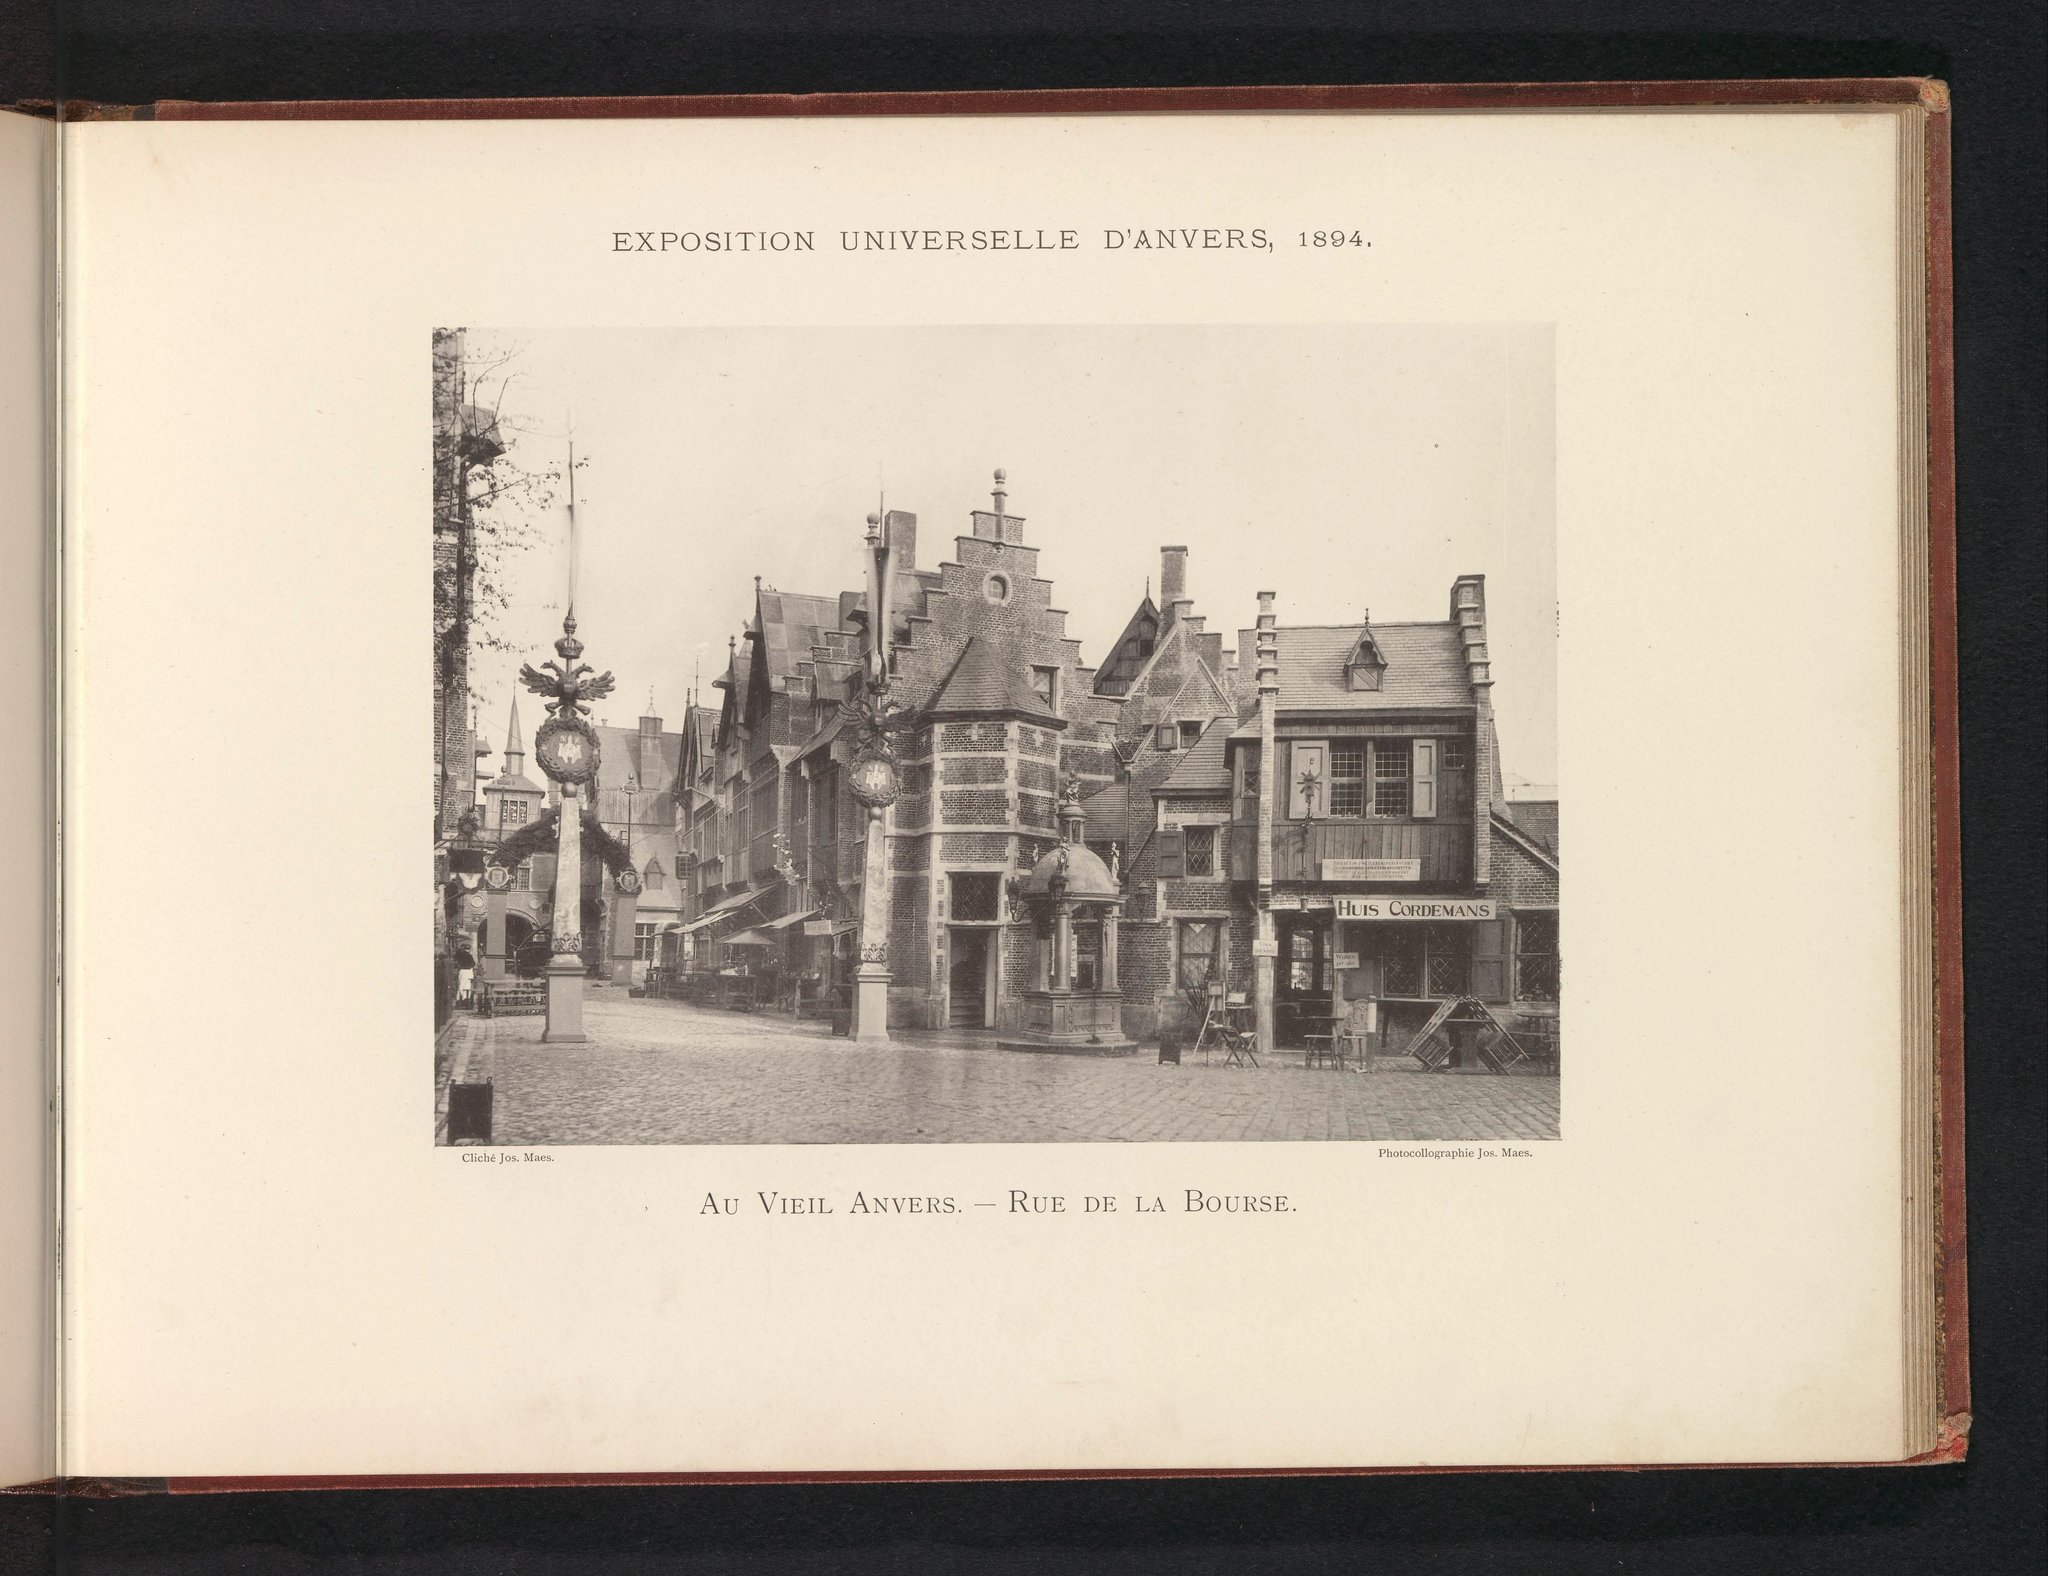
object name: page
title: Au vieil Anvers - Rue de la Bourse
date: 1890-1894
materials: paper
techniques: photograph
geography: antwerp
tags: façade (of house or building), street